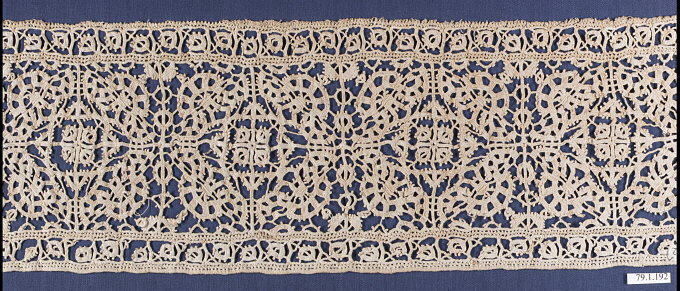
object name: insertion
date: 1600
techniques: lace